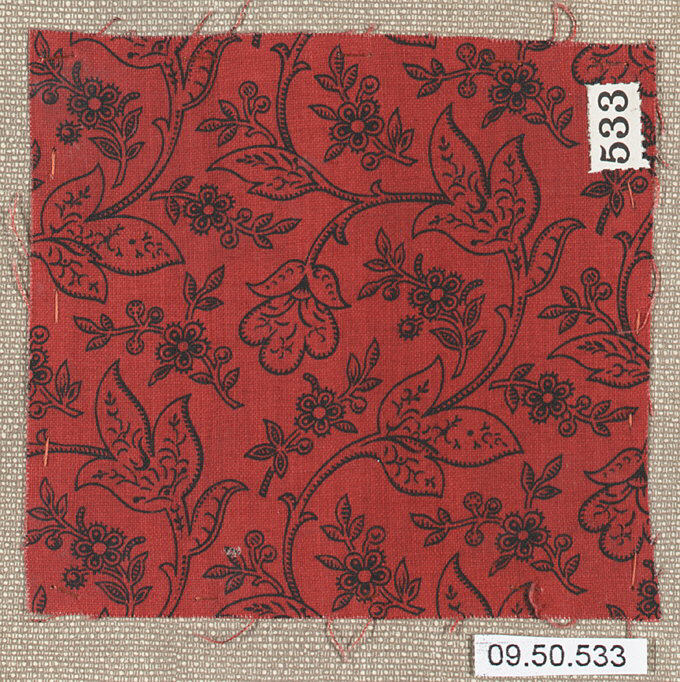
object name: piece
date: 1801-1900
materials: cotton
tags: flowers,leaves